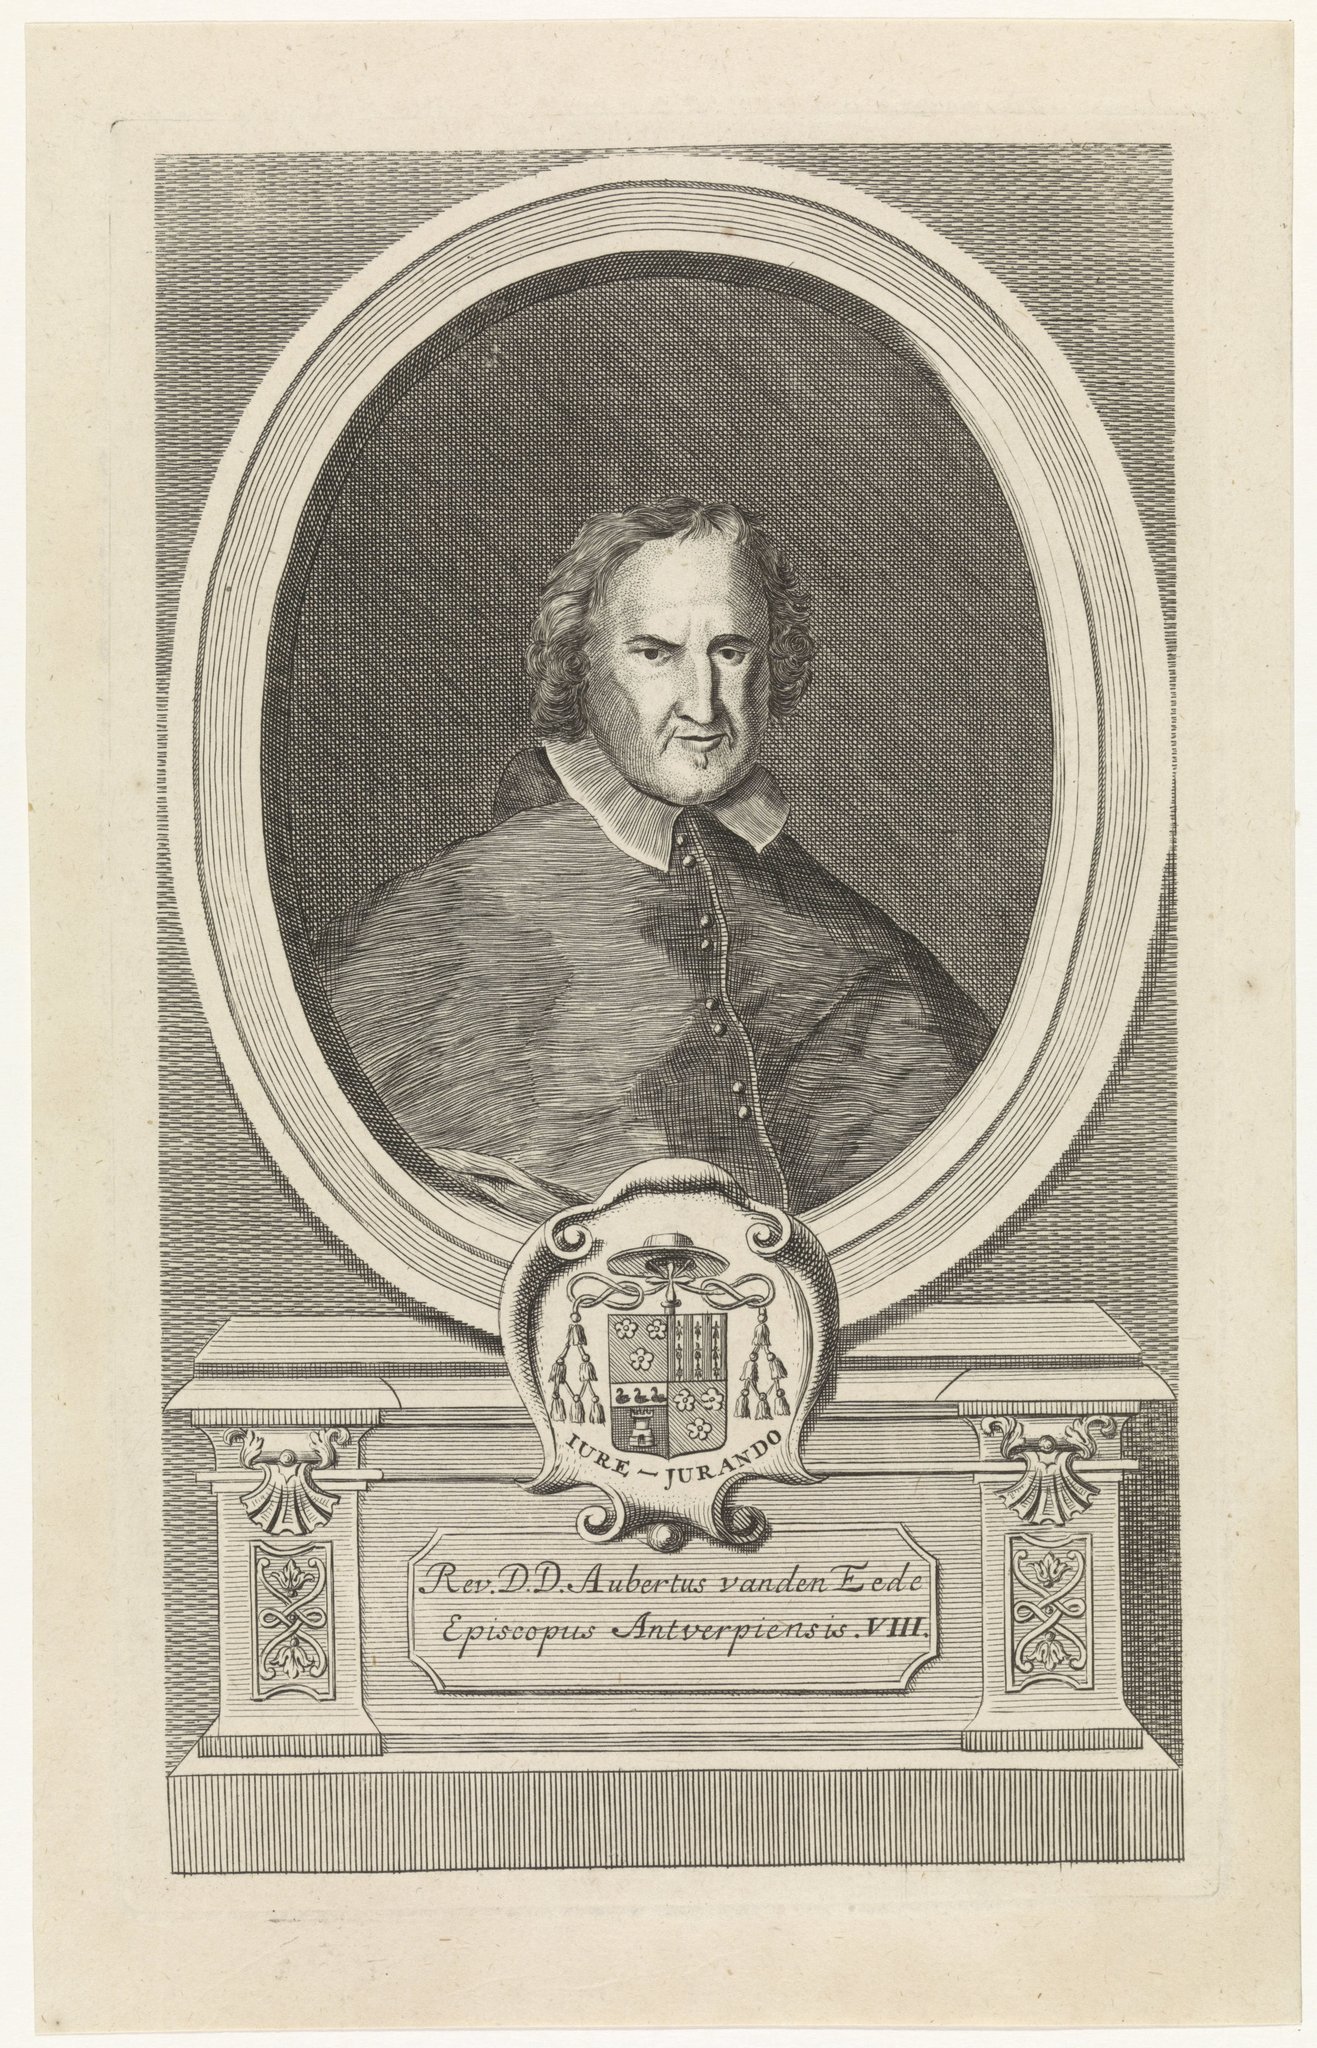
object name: book illustration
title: Portret van Aubertus van den Eede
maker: jan baptist jongelinx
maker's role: print maker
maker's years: 1689-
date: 1710-1725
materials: paper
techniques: engraving, etching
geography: antwerp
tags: brussels, aubertus van den eede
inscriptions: collector's mark: Lugt 2228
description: Busteportret van de bisschop Aubertus van den Eede. Het portret is gevat in een ovale omlijsting met het wapenschild van de geportretteerde en een motto in het Latijn. In een kader een tweeregelig onderschrift in het Latijn.